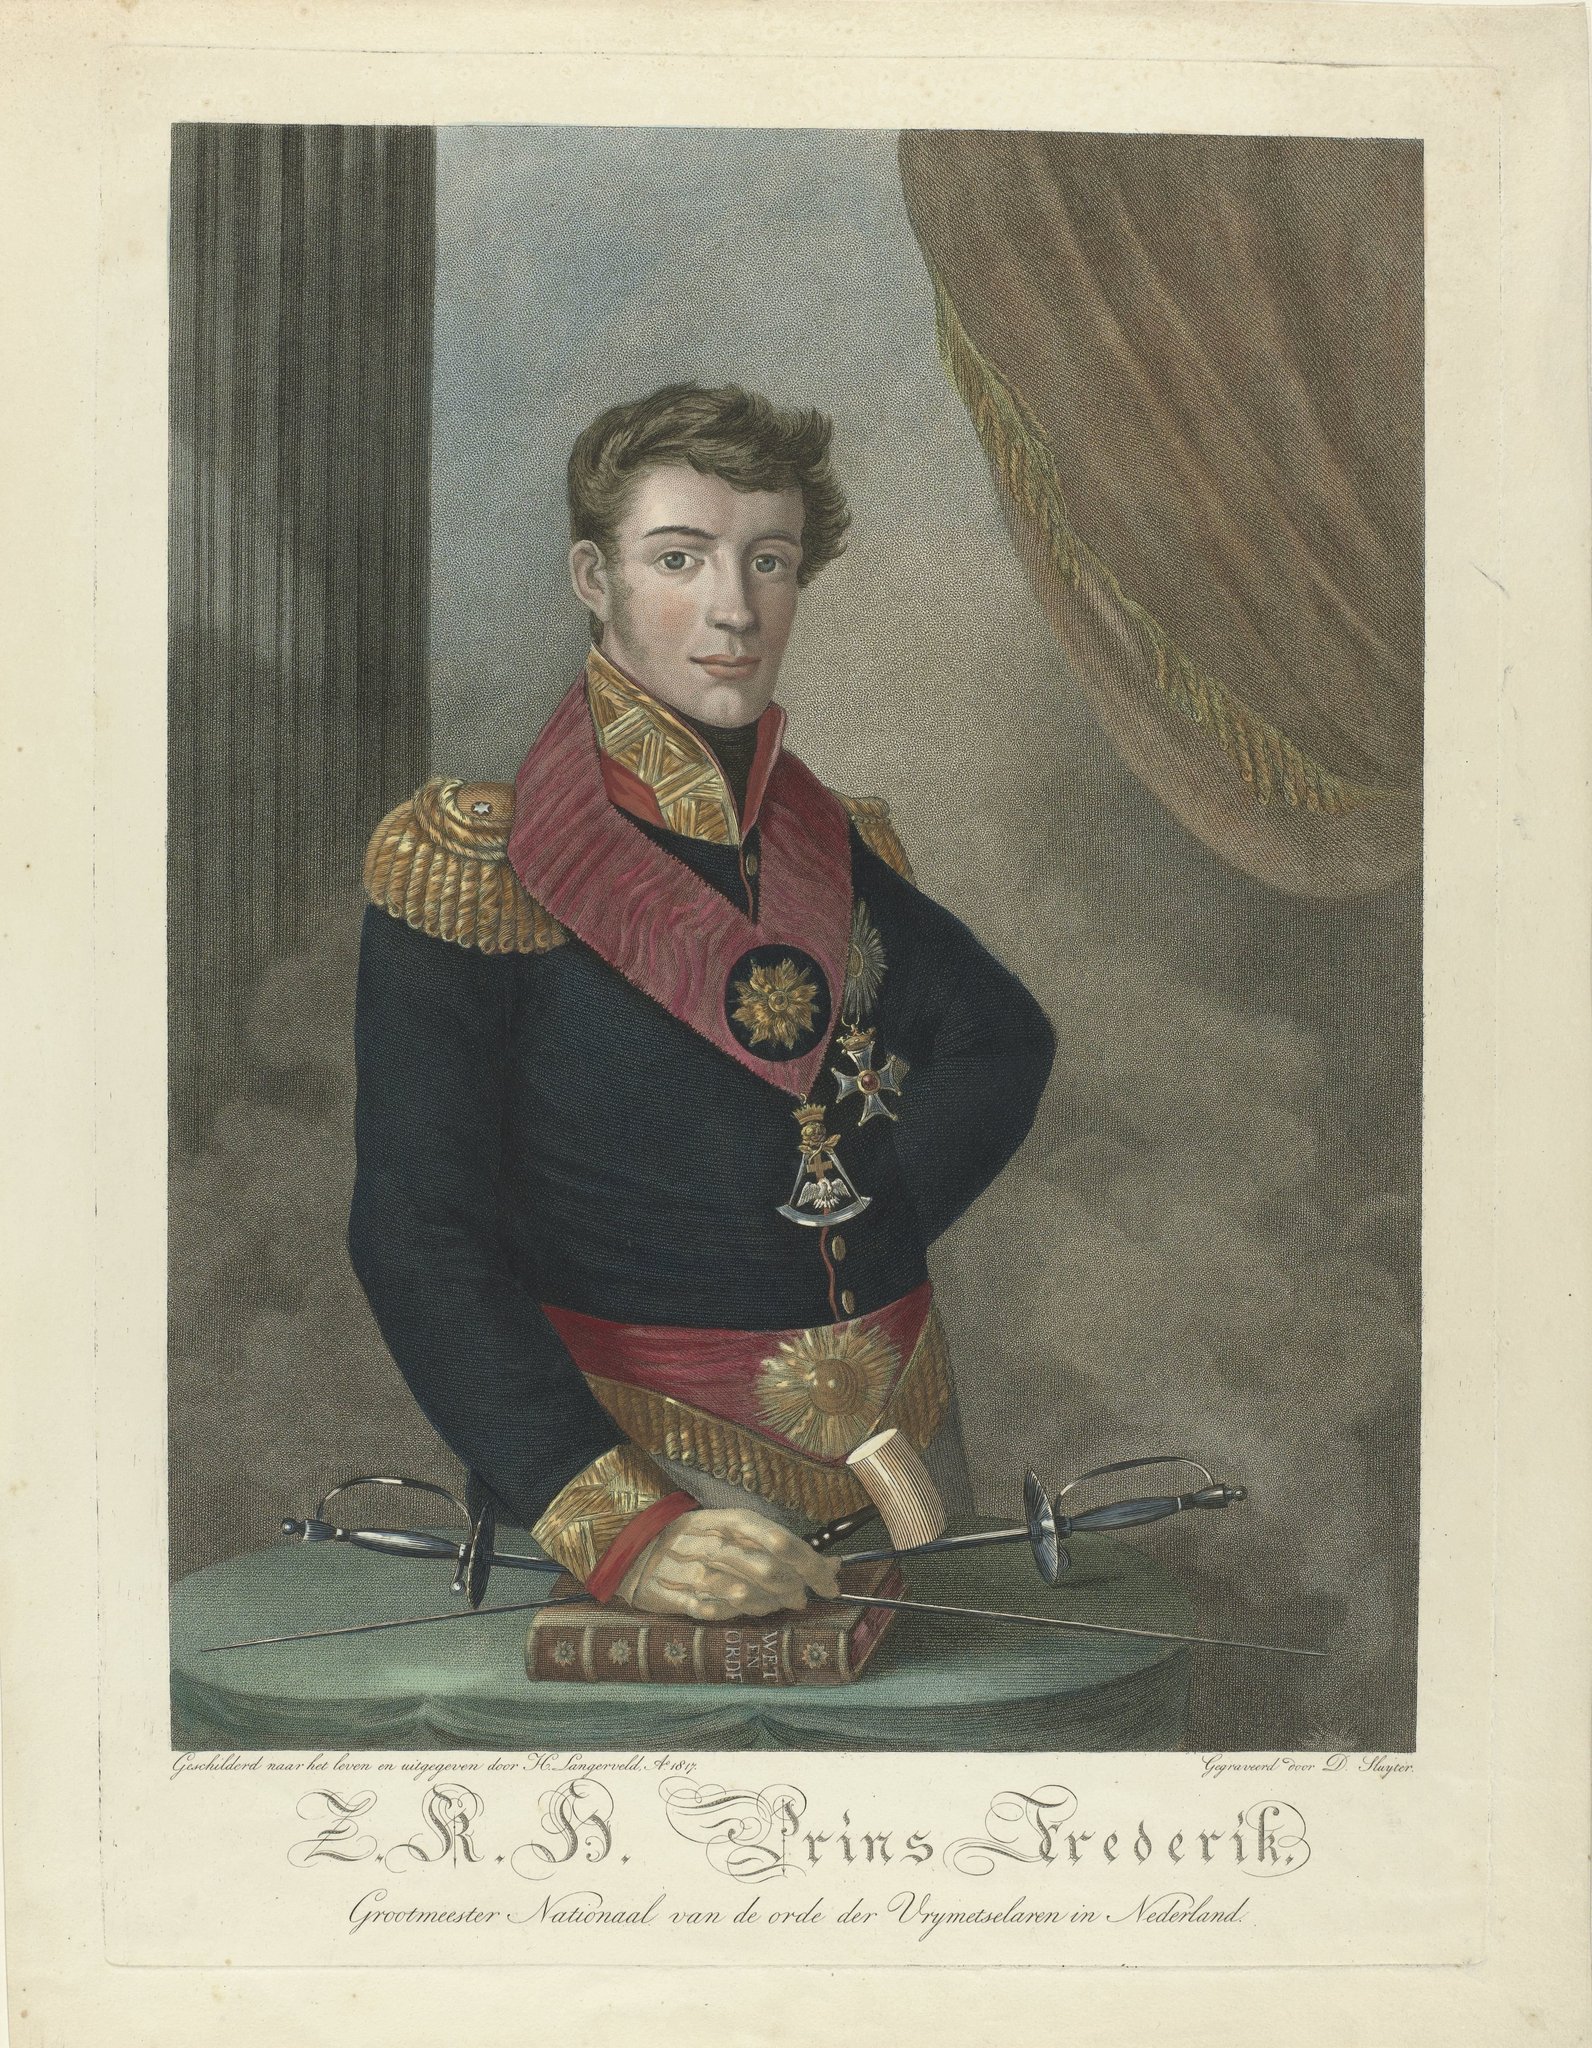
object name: print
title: Portret van Frederik, prins der Nederlanden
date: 1817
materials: paper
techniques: engraving, etching, hand coloring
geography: amsterdam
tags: berlin, frederik (prins der nederlanden)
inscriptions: collector's mark: Lugt 963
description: Portret van Frederik als grootmeester der Vrijmetselaren. In zijn rechterhand een hamer. Daaronder ligt een boek met twee gekruiste degens. In de ondermarge zijn naam en titels.